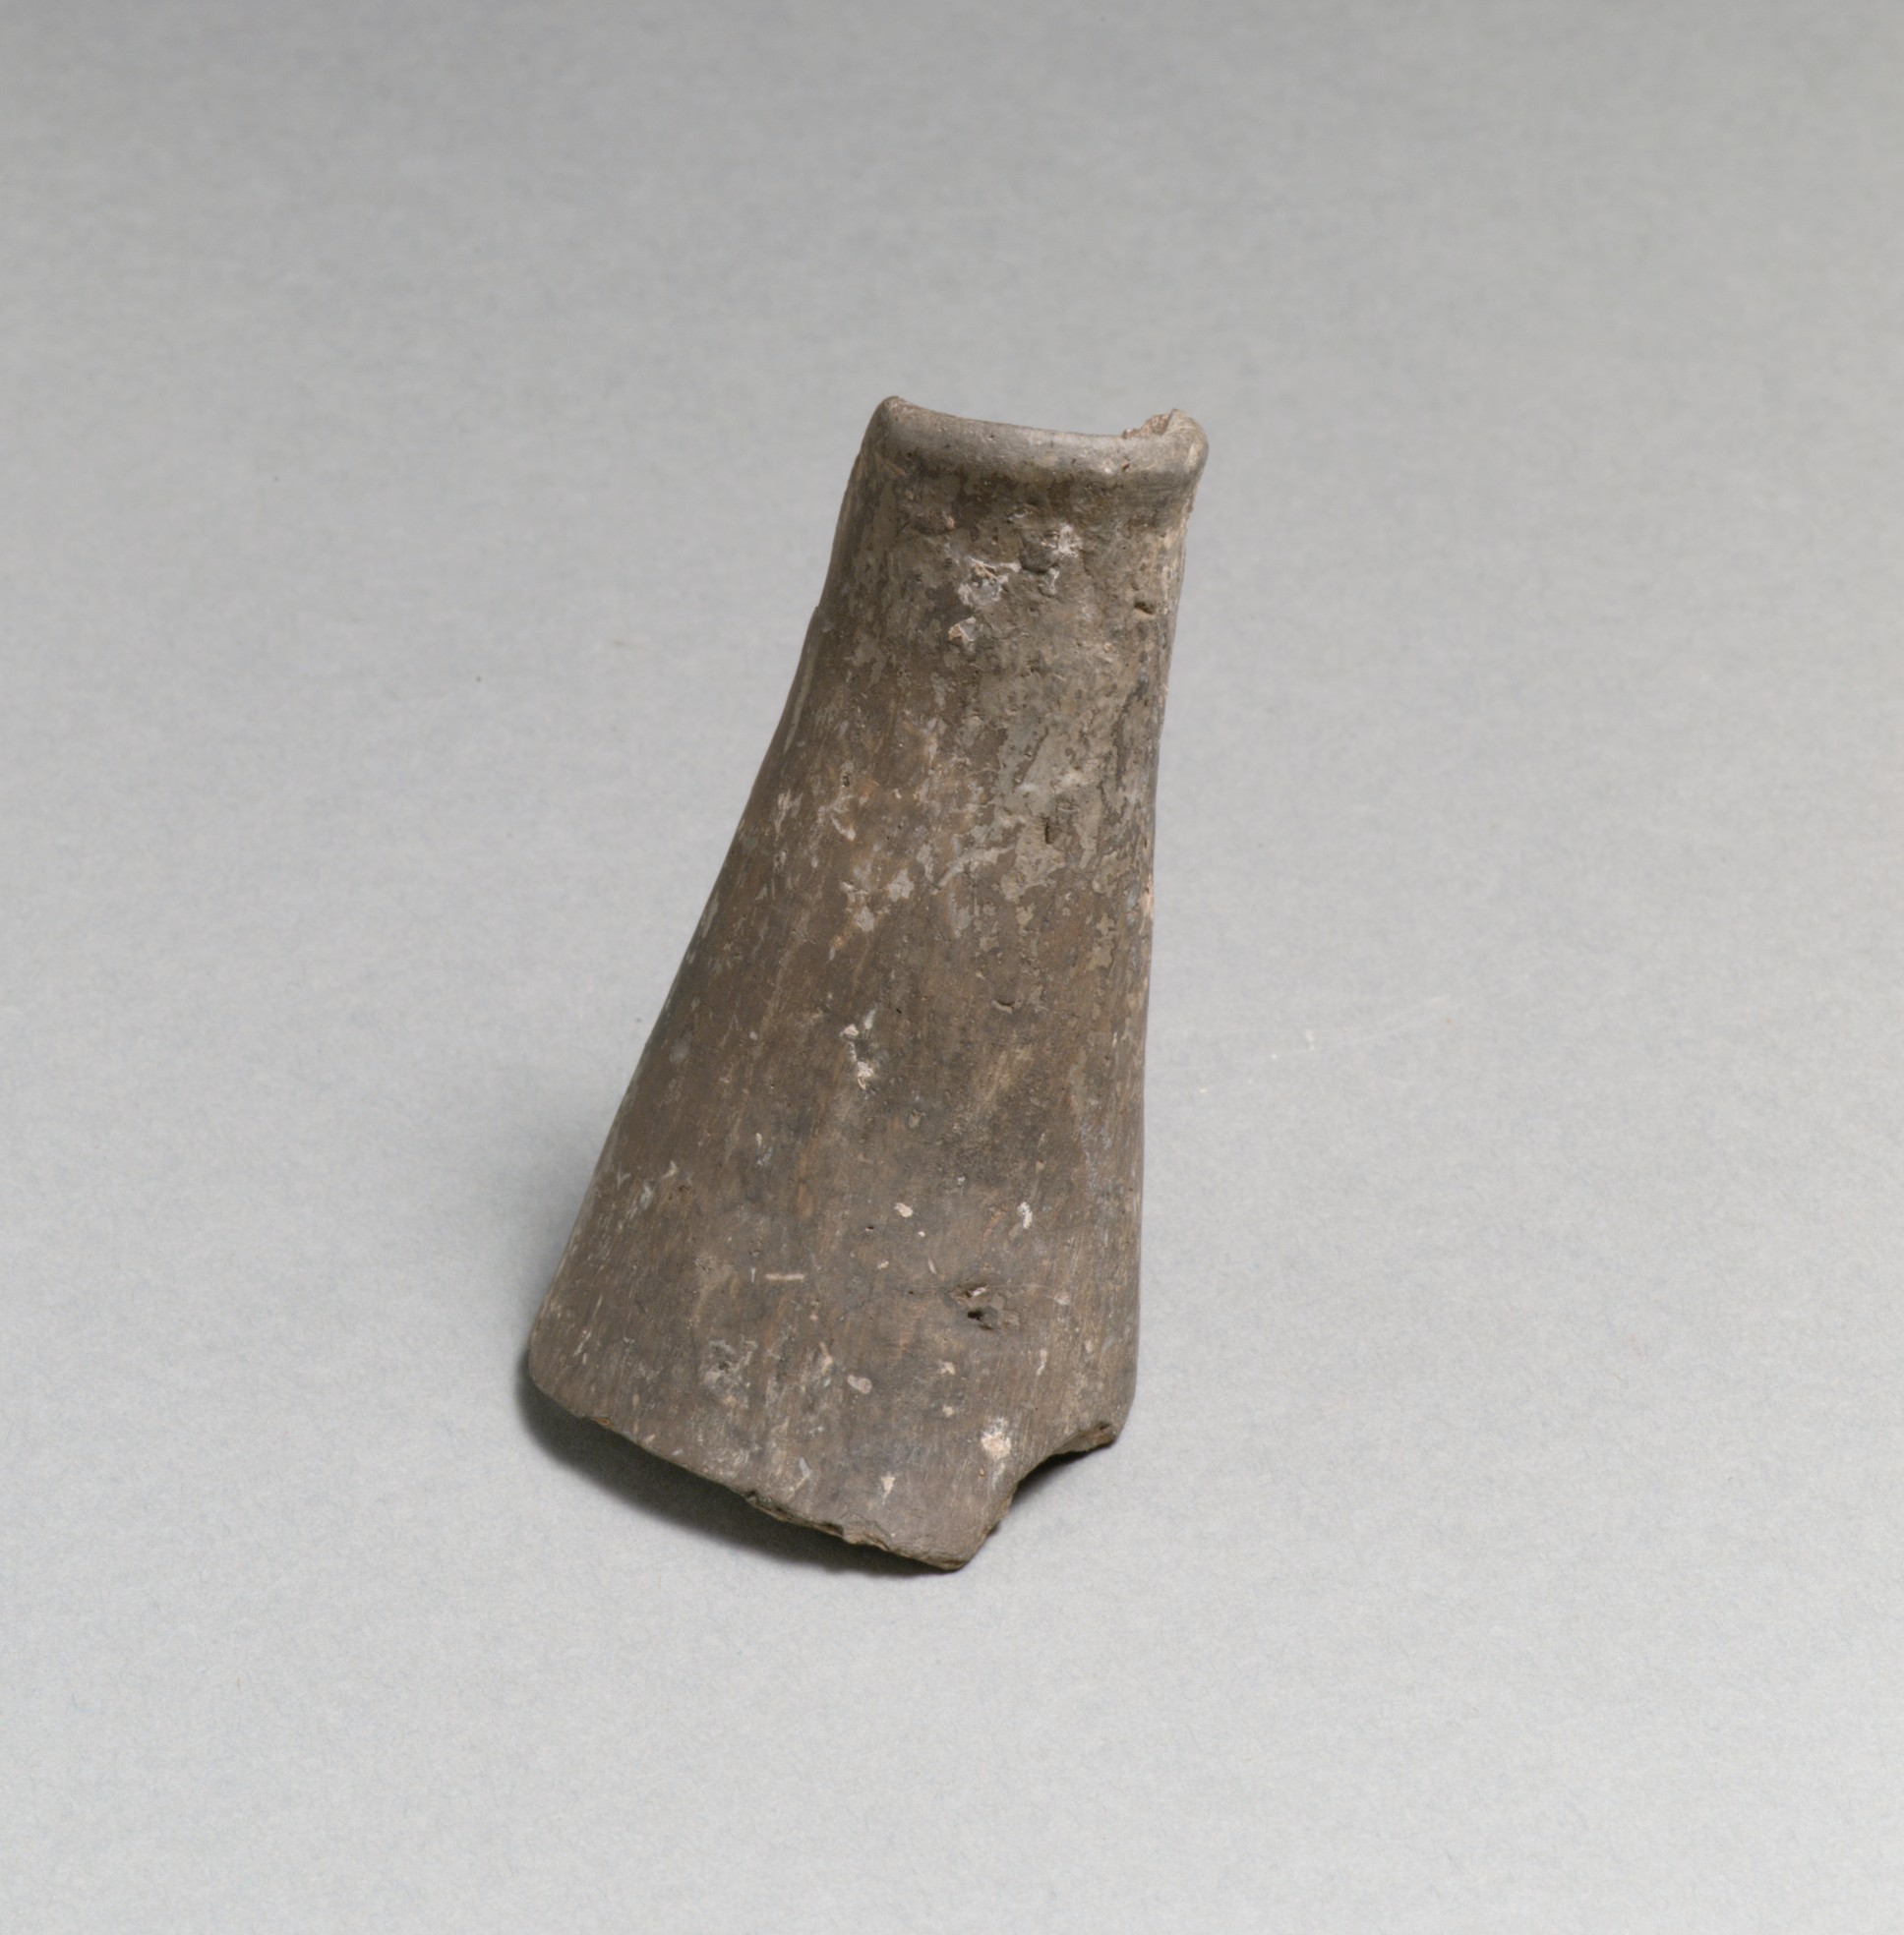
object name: jug beak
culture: minoan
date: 2600-2000 BCE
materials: terracotta